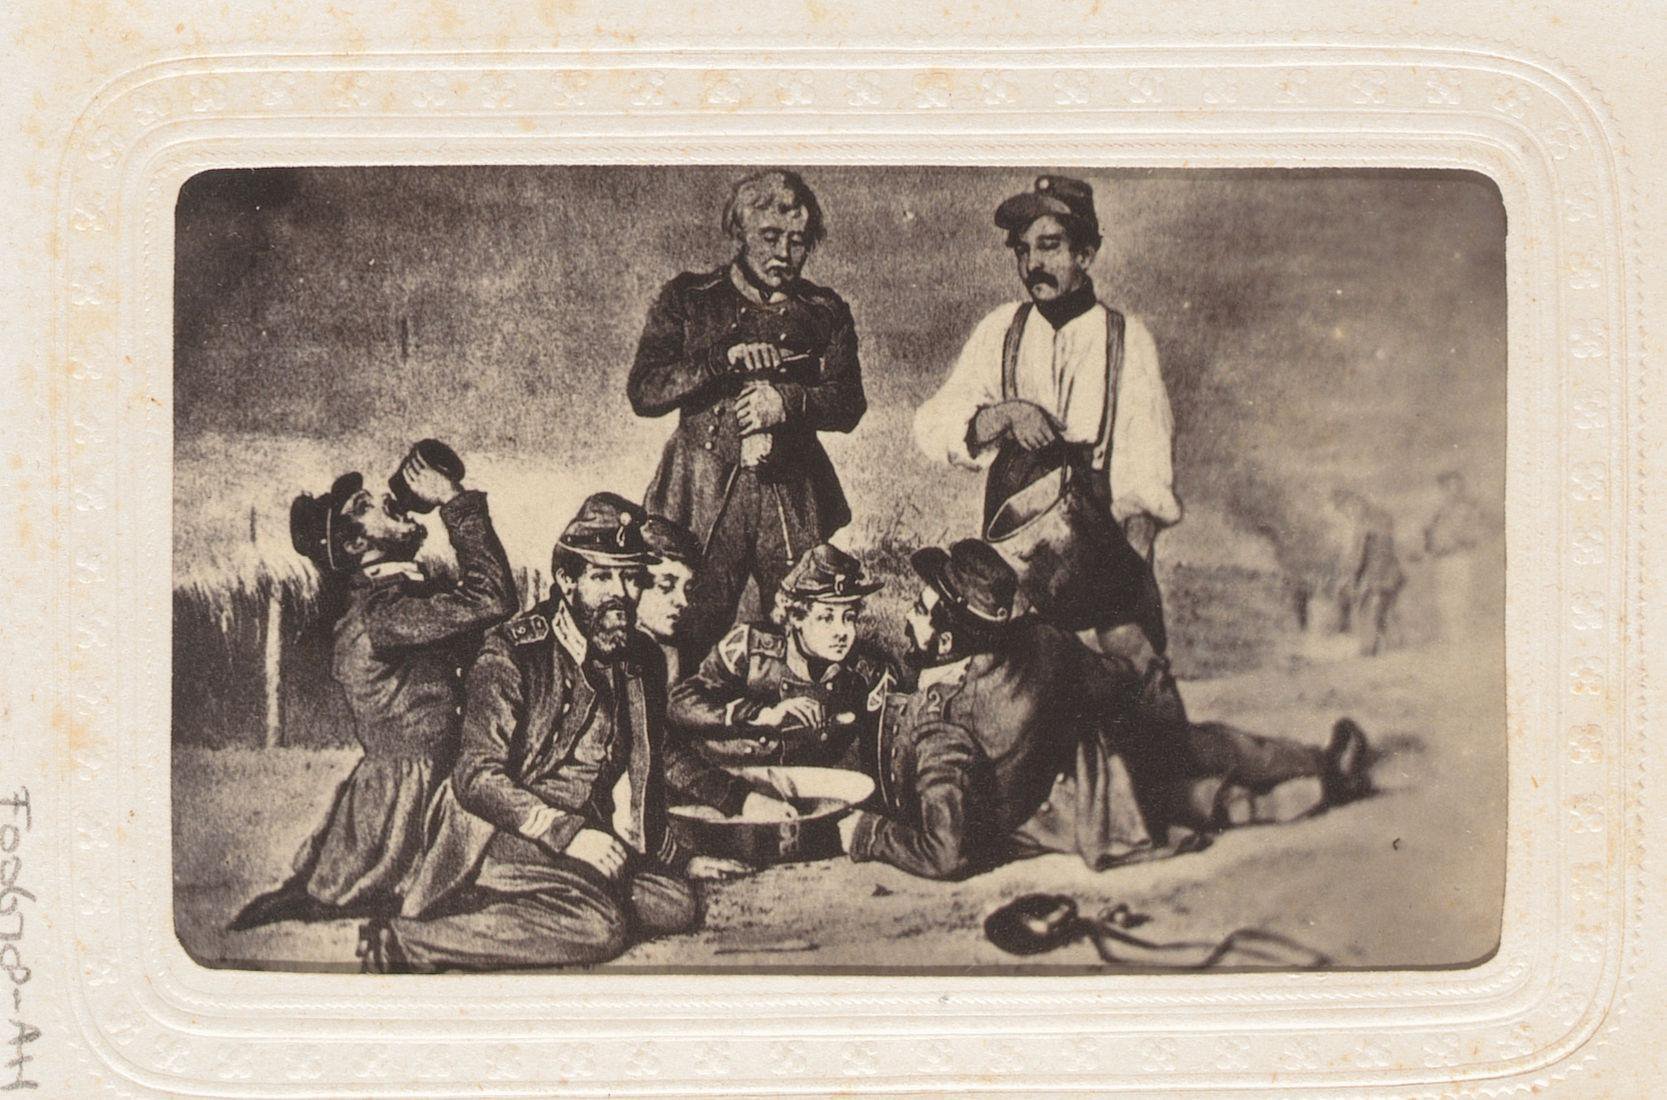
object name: carte de visite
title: Fotoreproductie van een prent met schaftende soldaten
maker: Anonymous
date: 1860-1880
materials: cardboard, photographic support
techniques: albumen print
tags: meals ~ military service (+ infantry)